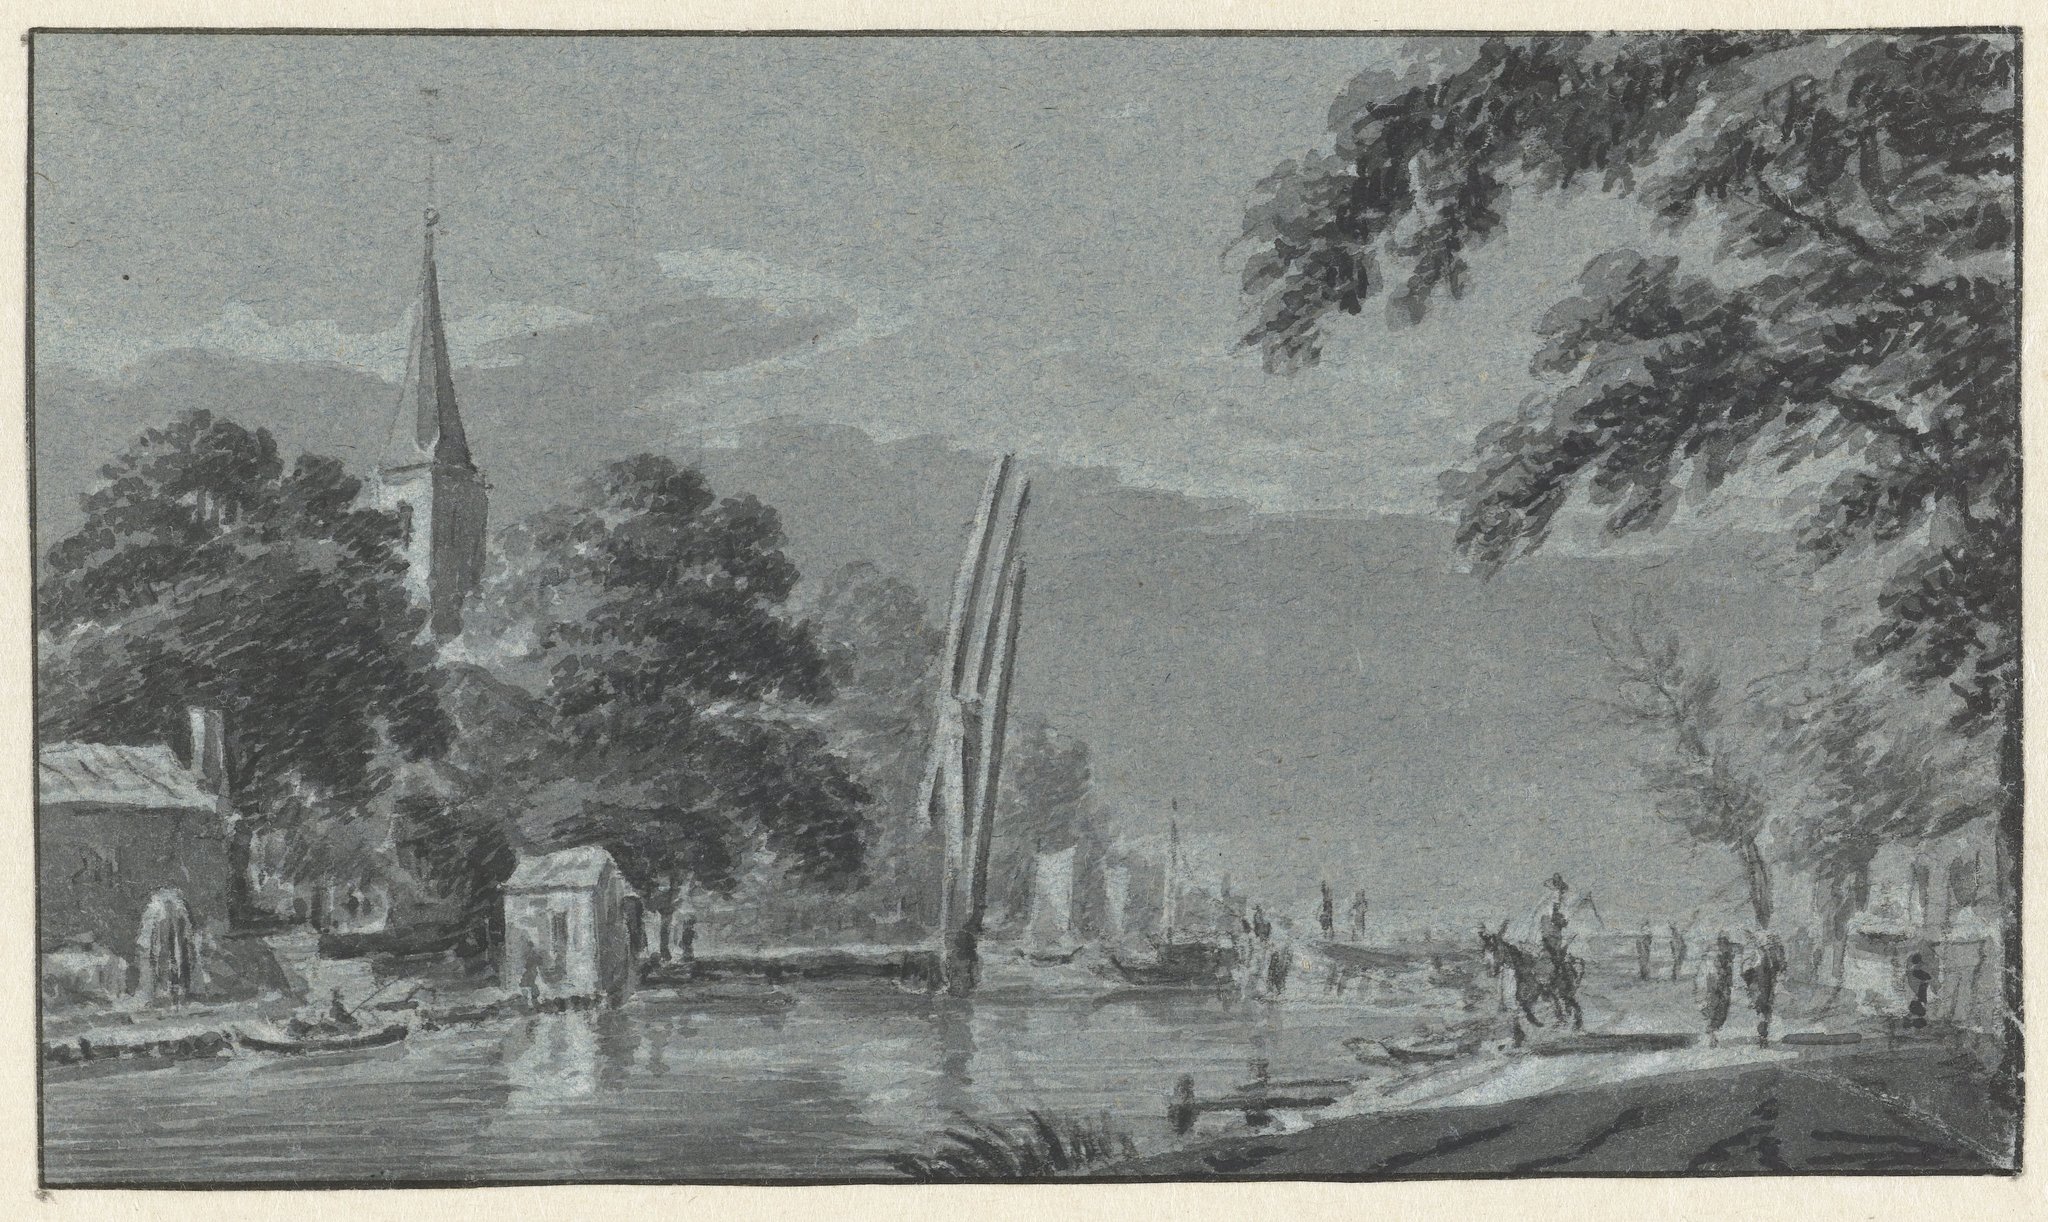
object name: drawing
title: Een dorp bij een trekvaart met een opgehaalde brug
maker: hendrik spilman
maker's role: draughtsman, painter, print maker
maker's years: 1721-1784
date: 1733-1784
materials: ink, paper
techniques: pen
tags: village, public convenience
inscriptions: name: ‘Spilman’